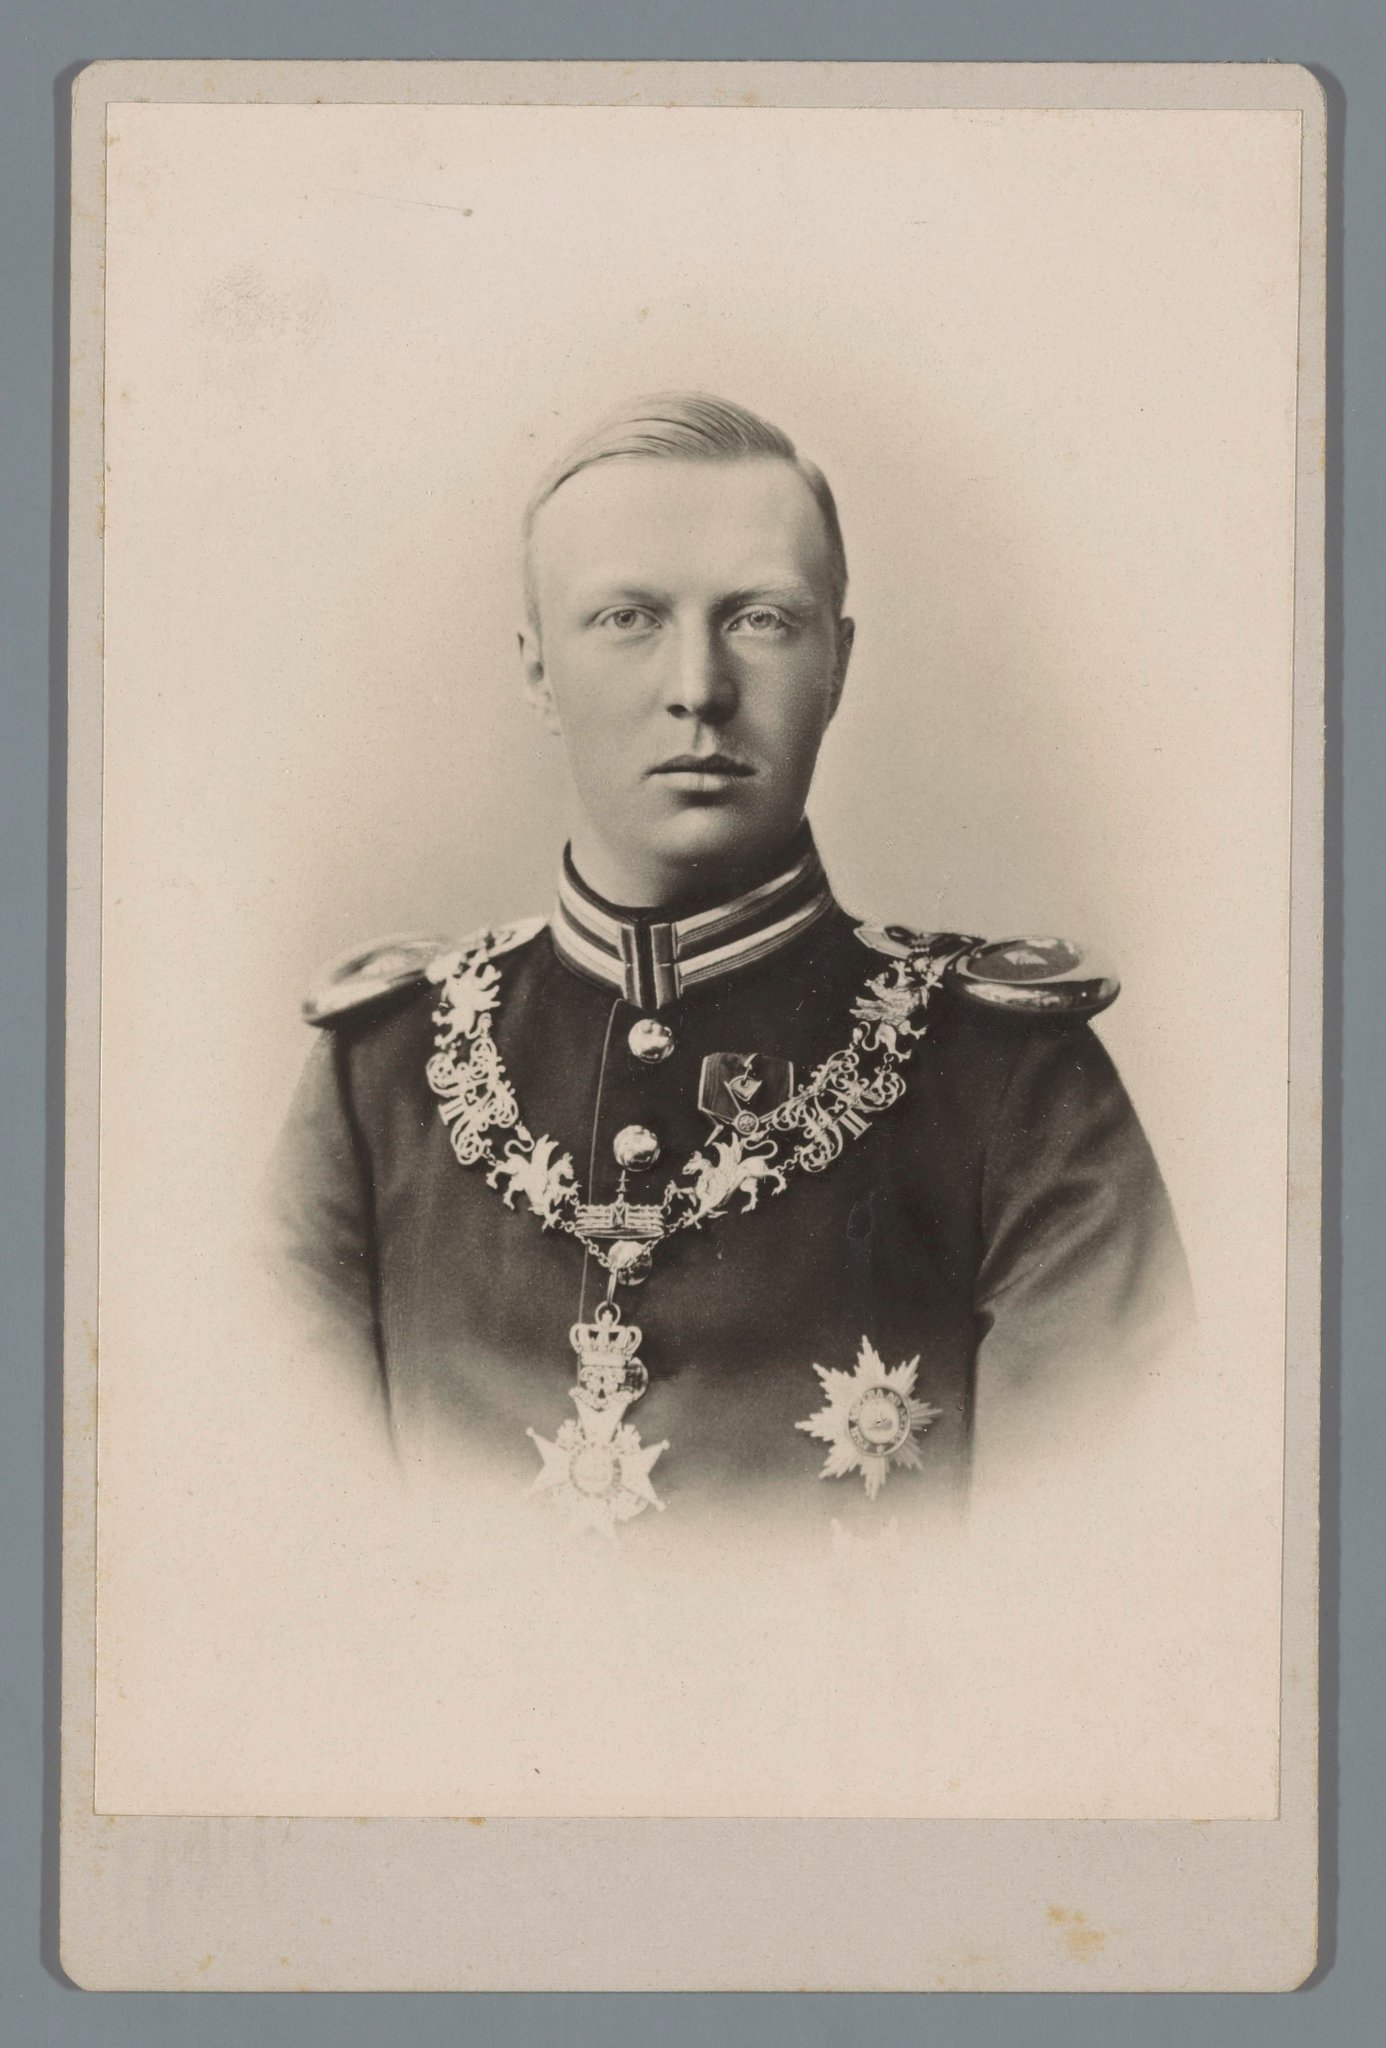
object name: cabinet photograph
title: Portret van prins Hendrik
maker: Anonymous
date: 1900-1901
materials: cardboard, photographic support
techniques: collodion silver print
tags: the hague, hendrik (prins der nederlanden (1876-1934)), prince, historical persons